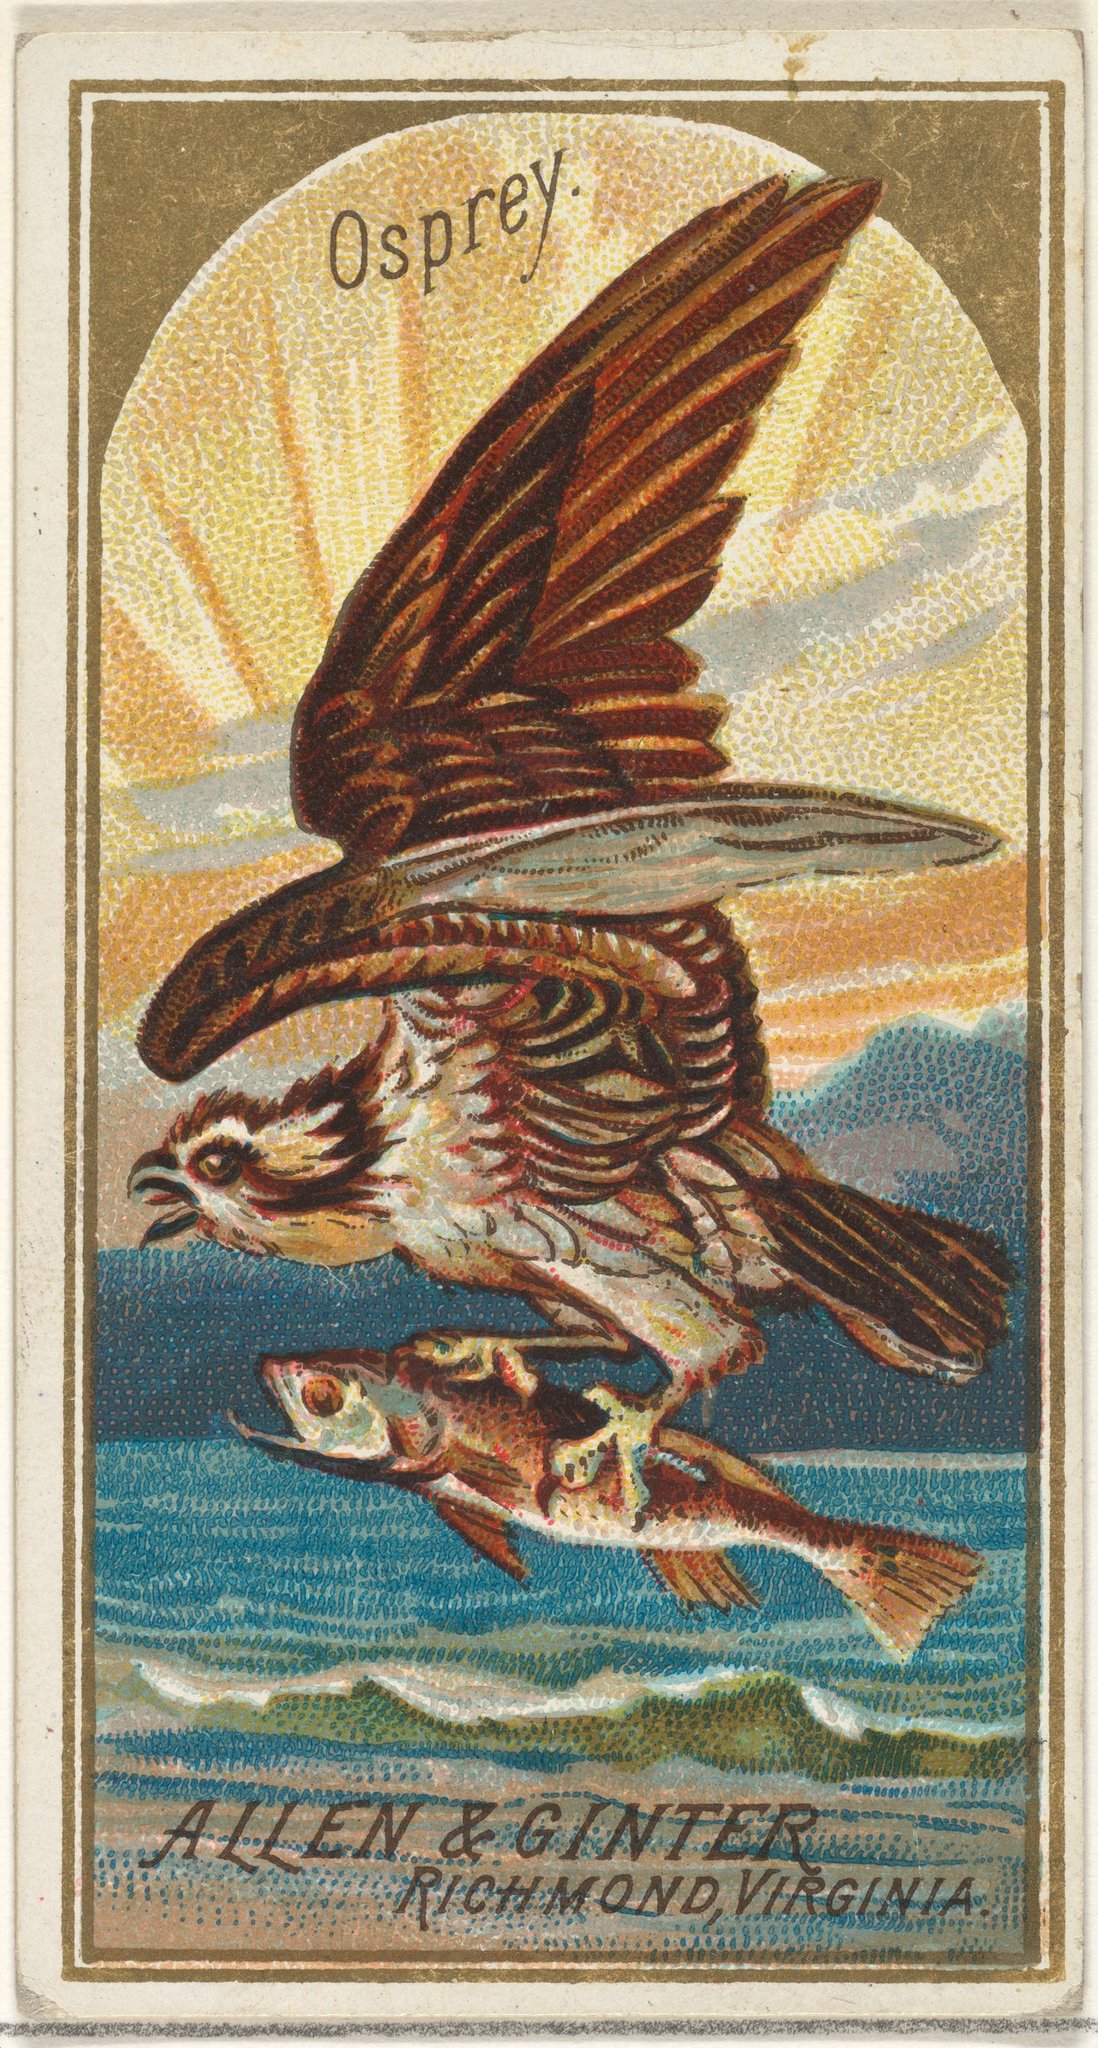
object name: print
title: Osprey, from the Birds of America series (N4) for Allen & Ginter Cigarettes Brands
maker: allen & ginter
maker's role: publisher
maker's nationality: american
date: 1888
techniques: color lithograph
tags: birds,fish